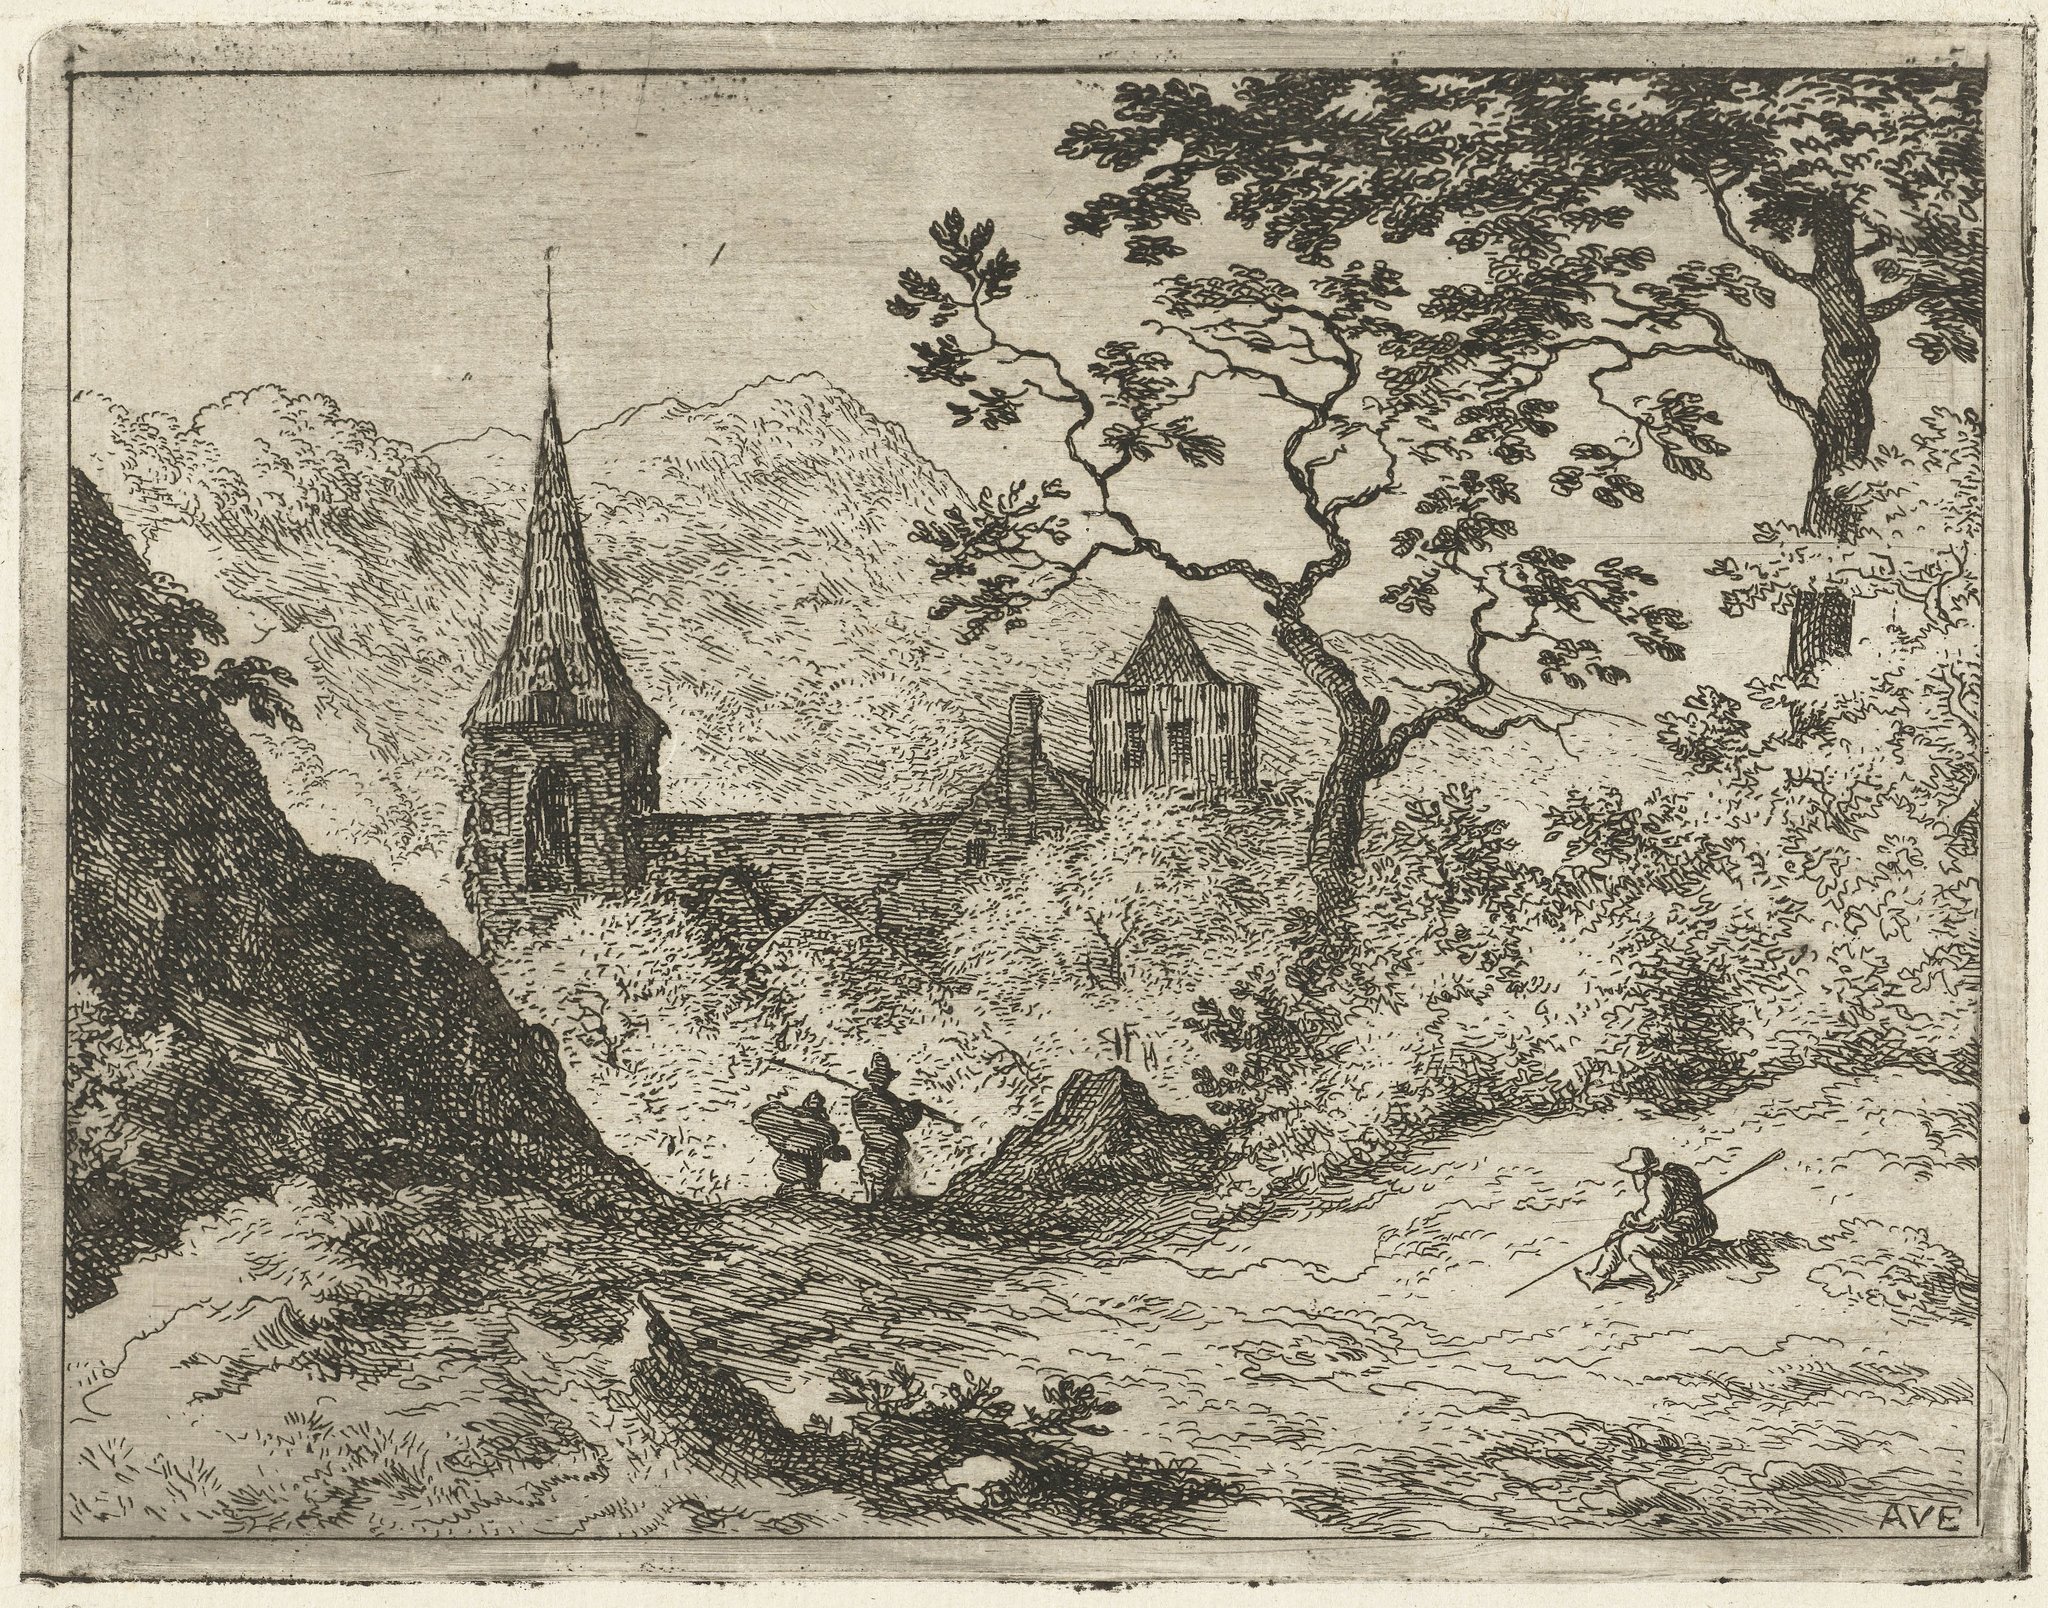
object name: print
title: Landschap met kerk in vallei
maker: allaert van everdingen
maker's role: draughtsman, painter, print maker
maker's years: 1621-1675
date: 1651-1675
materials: paper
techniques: etching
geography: netherlands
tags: tower (of house or building)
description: Berglandschap met op de voorgrond een zittende man en iets verderop twee wandelaars. In het dal een gebouw met een toren.